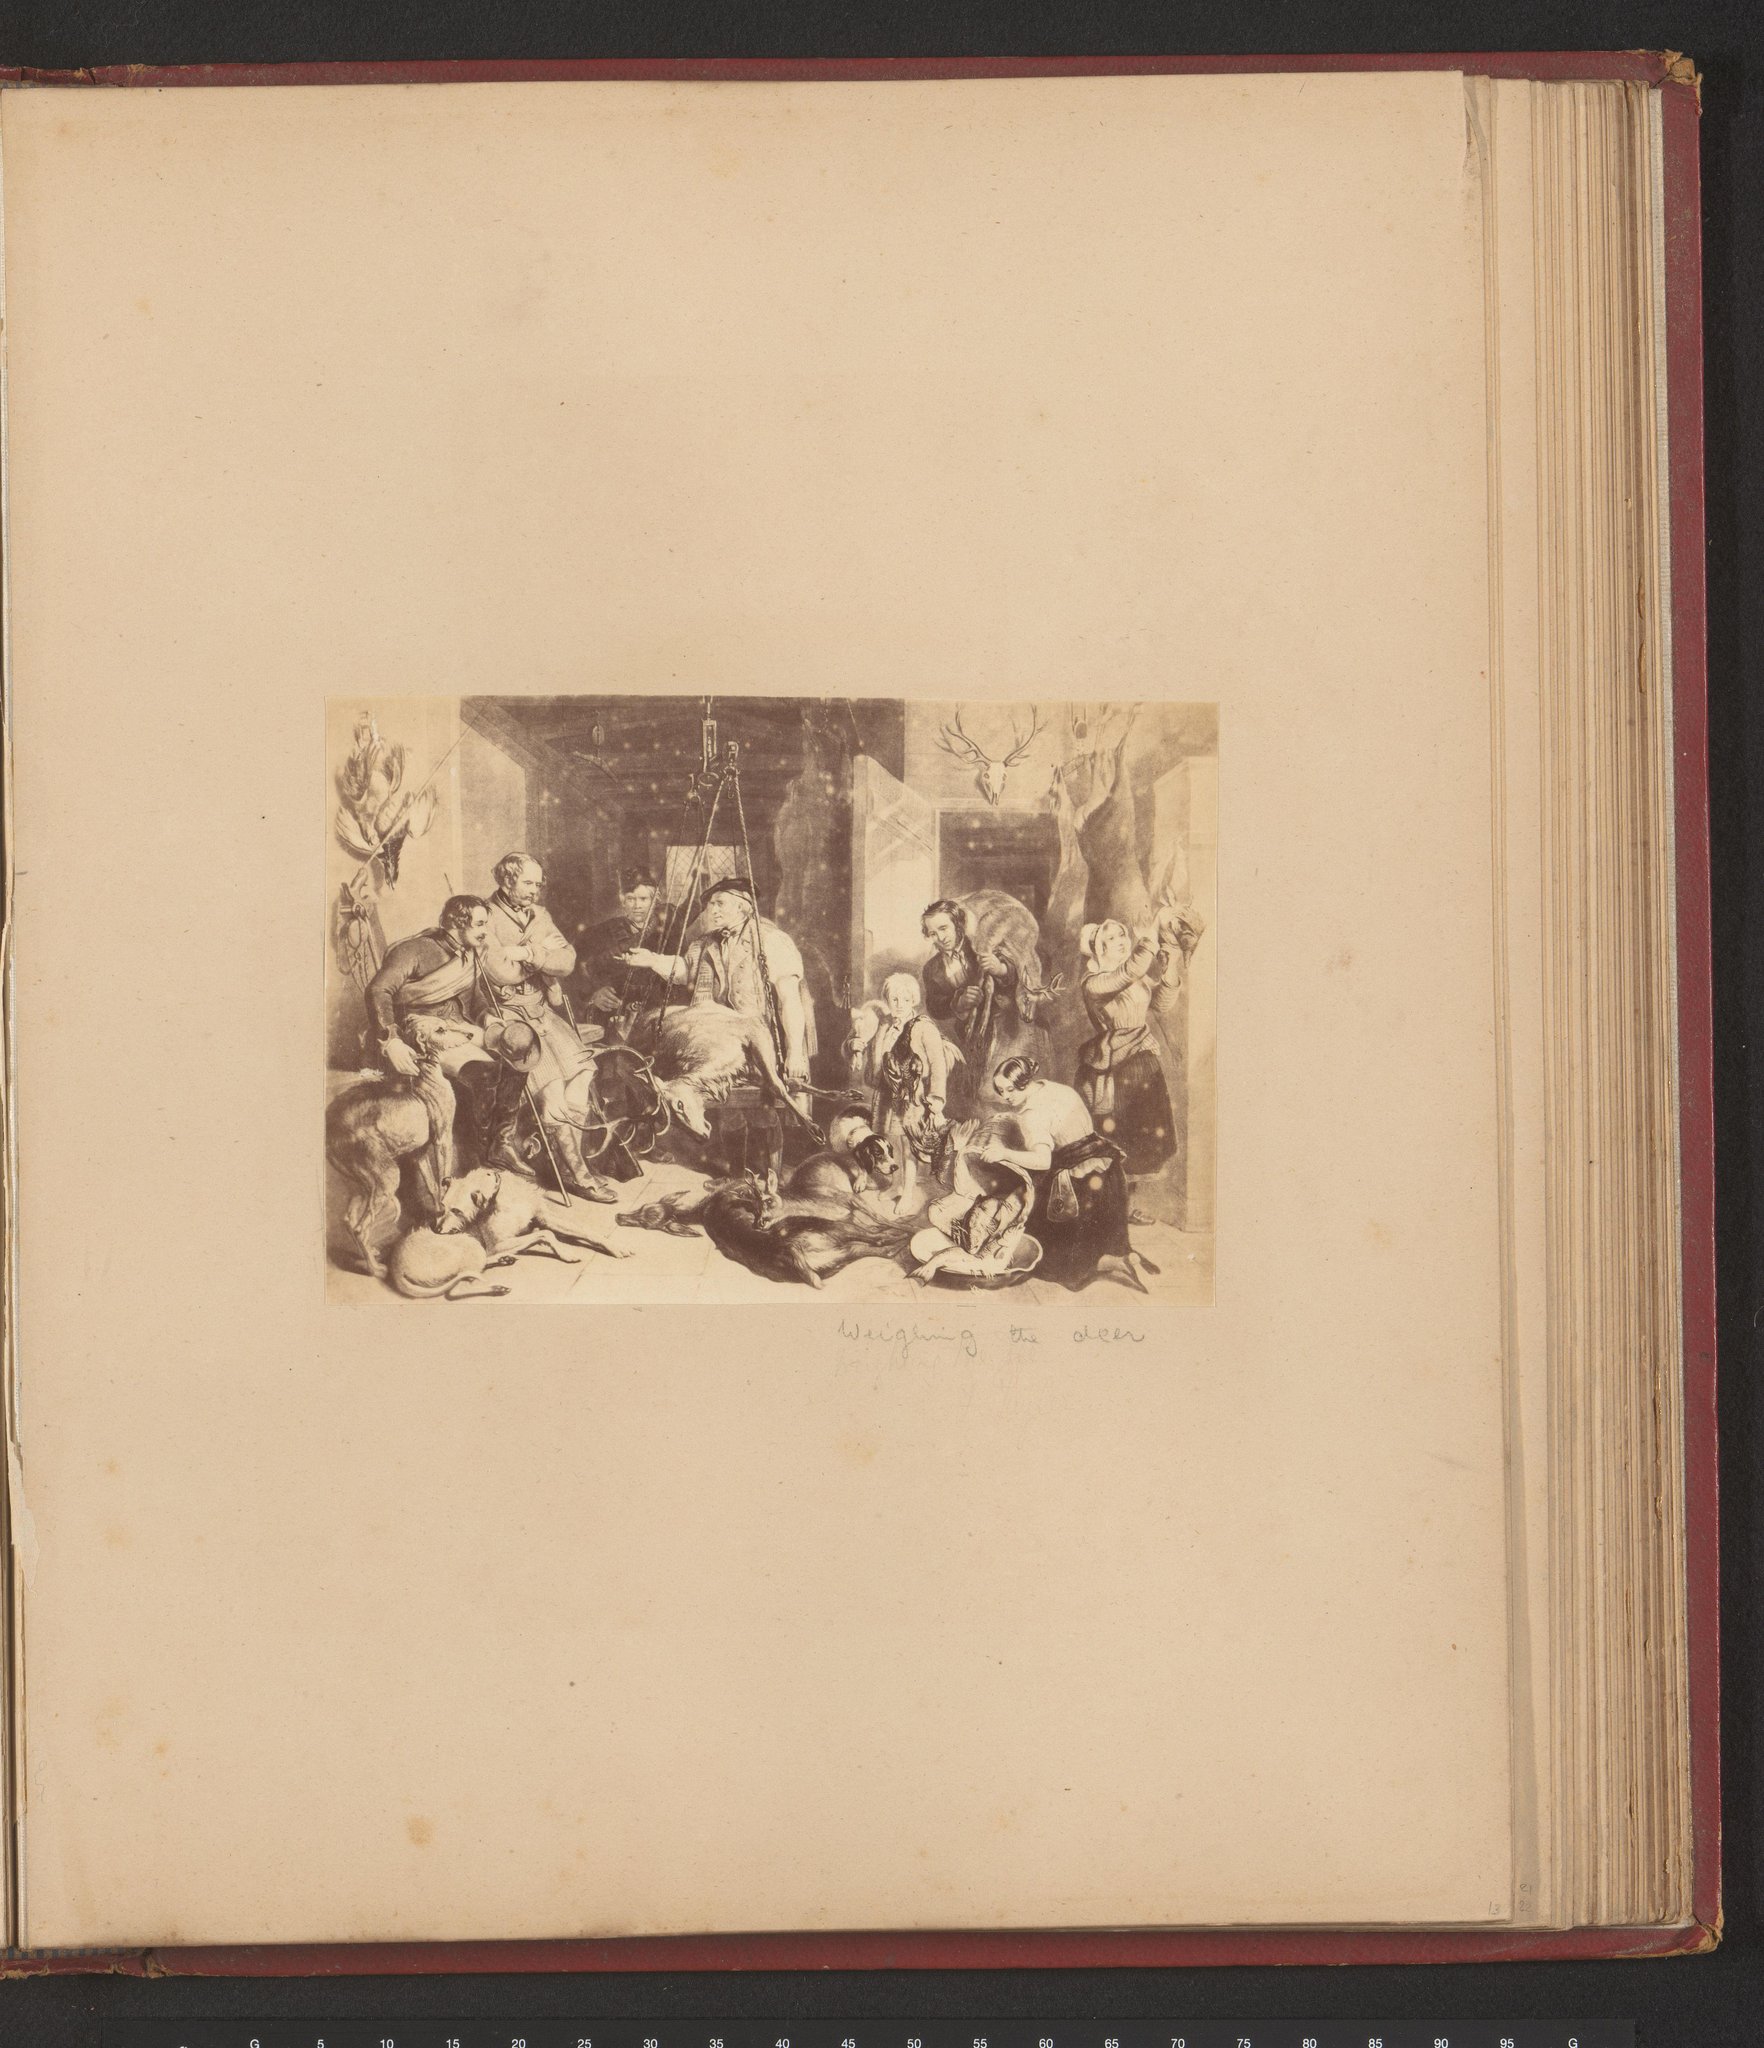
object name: reproduction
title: Weighing the deer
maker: Anonymous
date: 1875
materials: photographic support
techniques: albumen print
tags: weighing, hoofed animals: deer, hunter